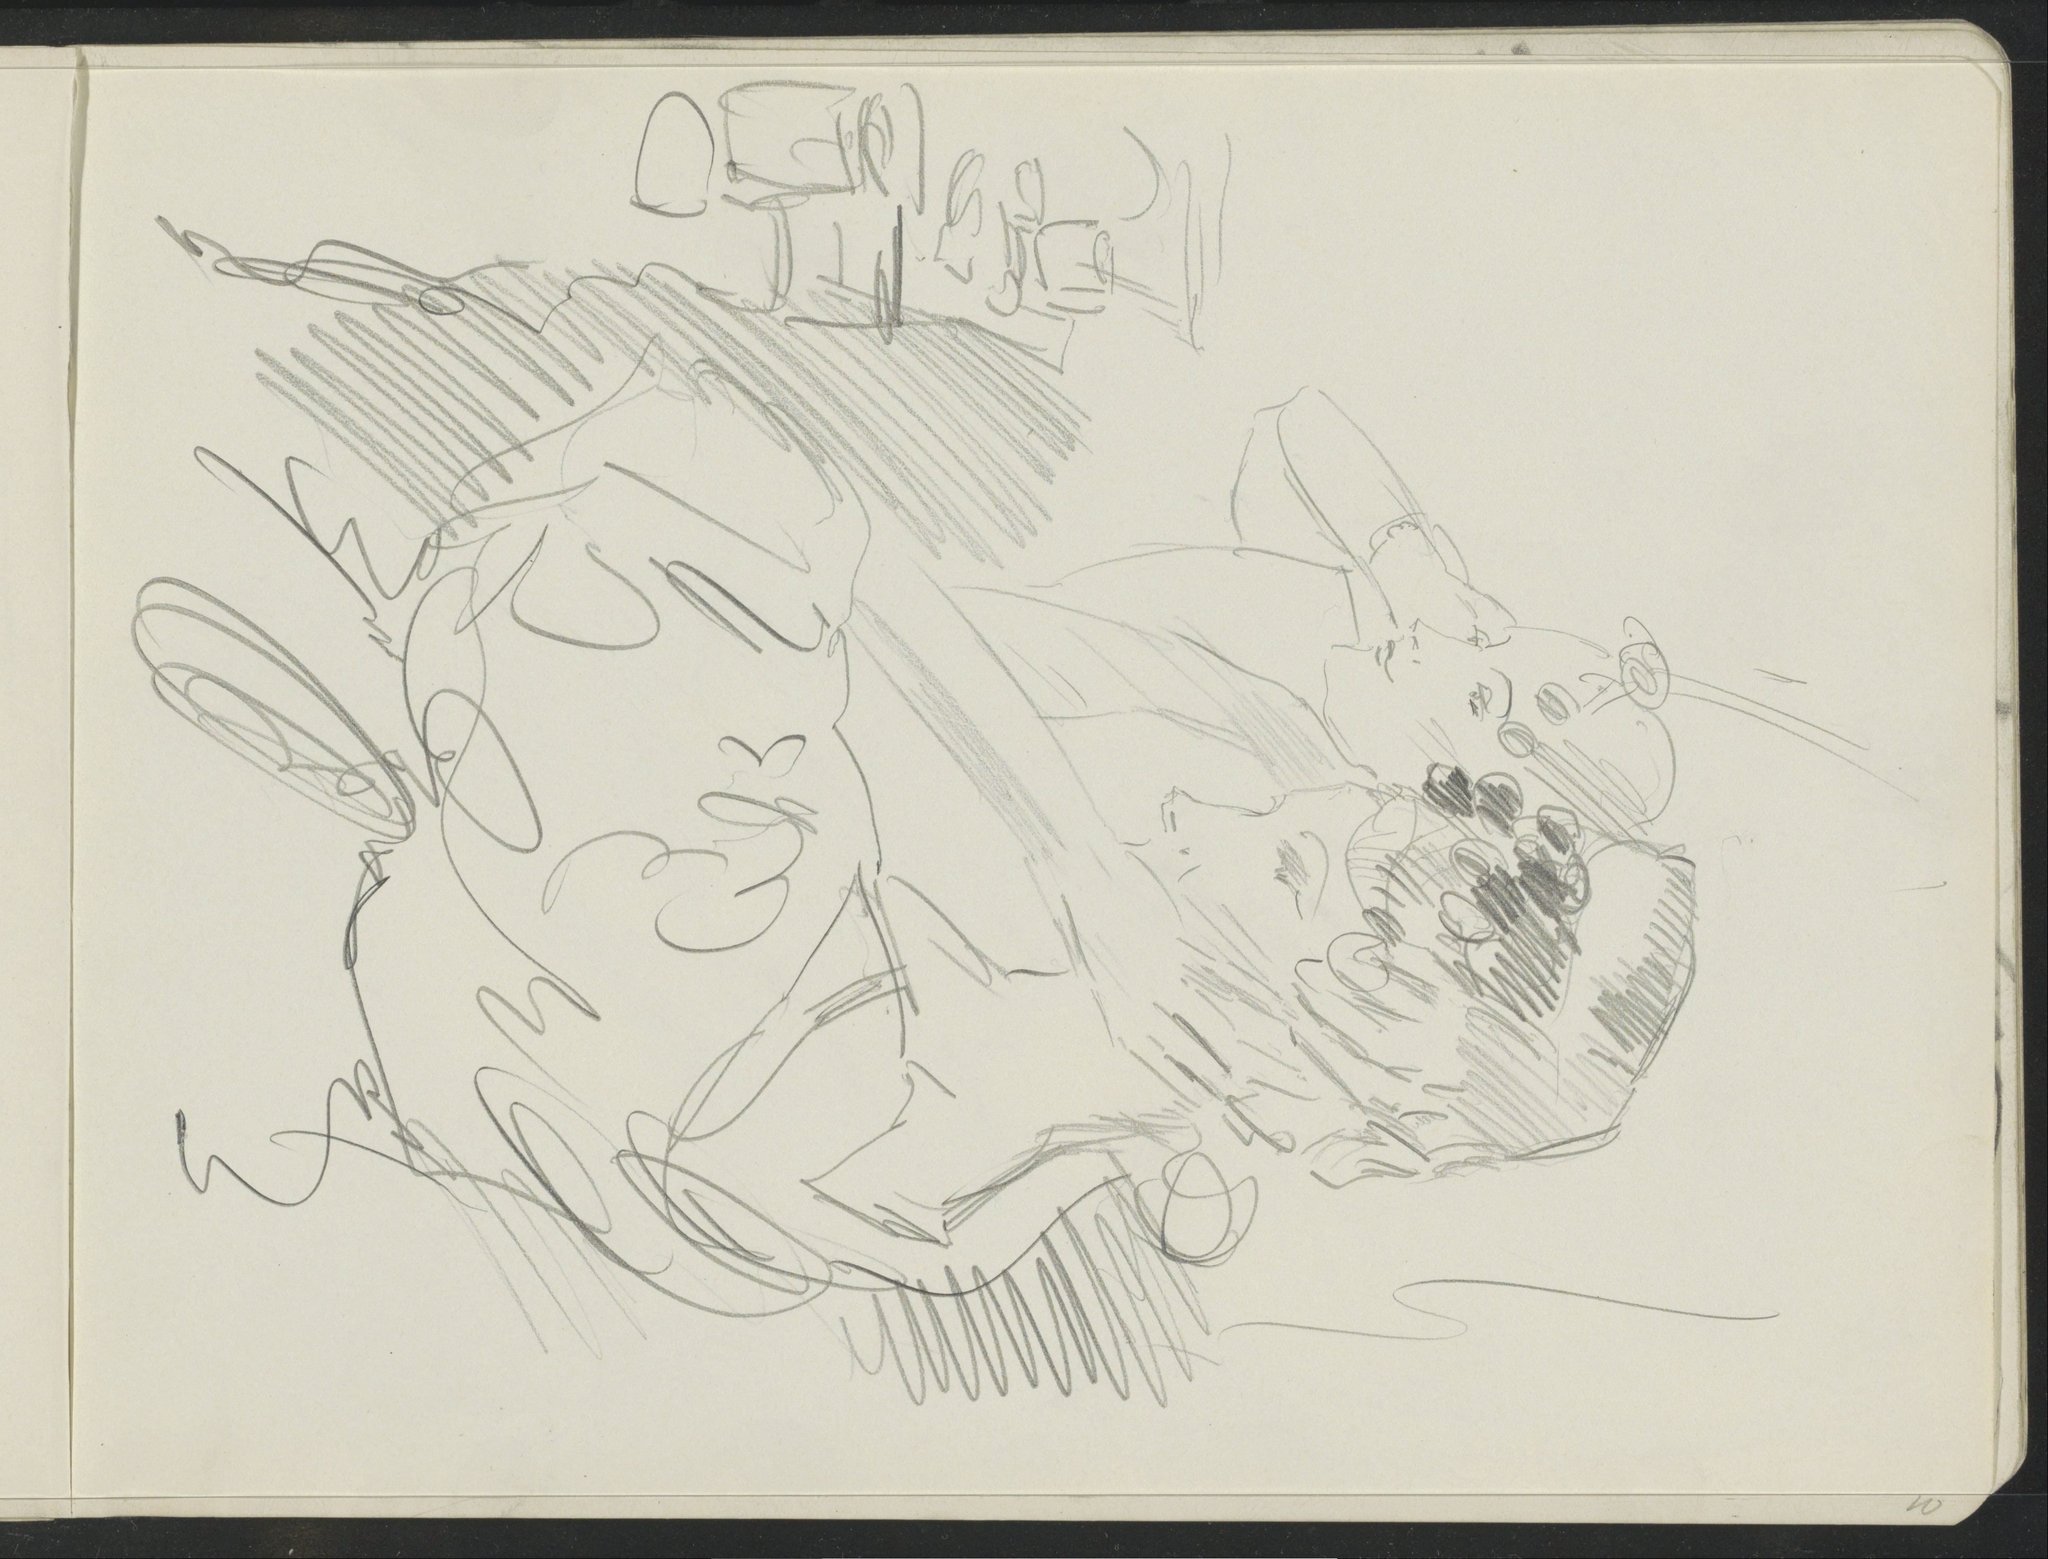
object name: sketchbook leaf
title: Twee vrouwen aan een kaptafel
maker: isaac israels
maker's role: draughtsman, painter, print maker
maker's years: 1865-1934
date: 1915-1934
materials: paper, pencil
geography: the hague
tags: adult woman (+ sitting), making toilet - aa - (for) women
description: Blad 10 recto uit schetsboek XVII met 31 bladen.